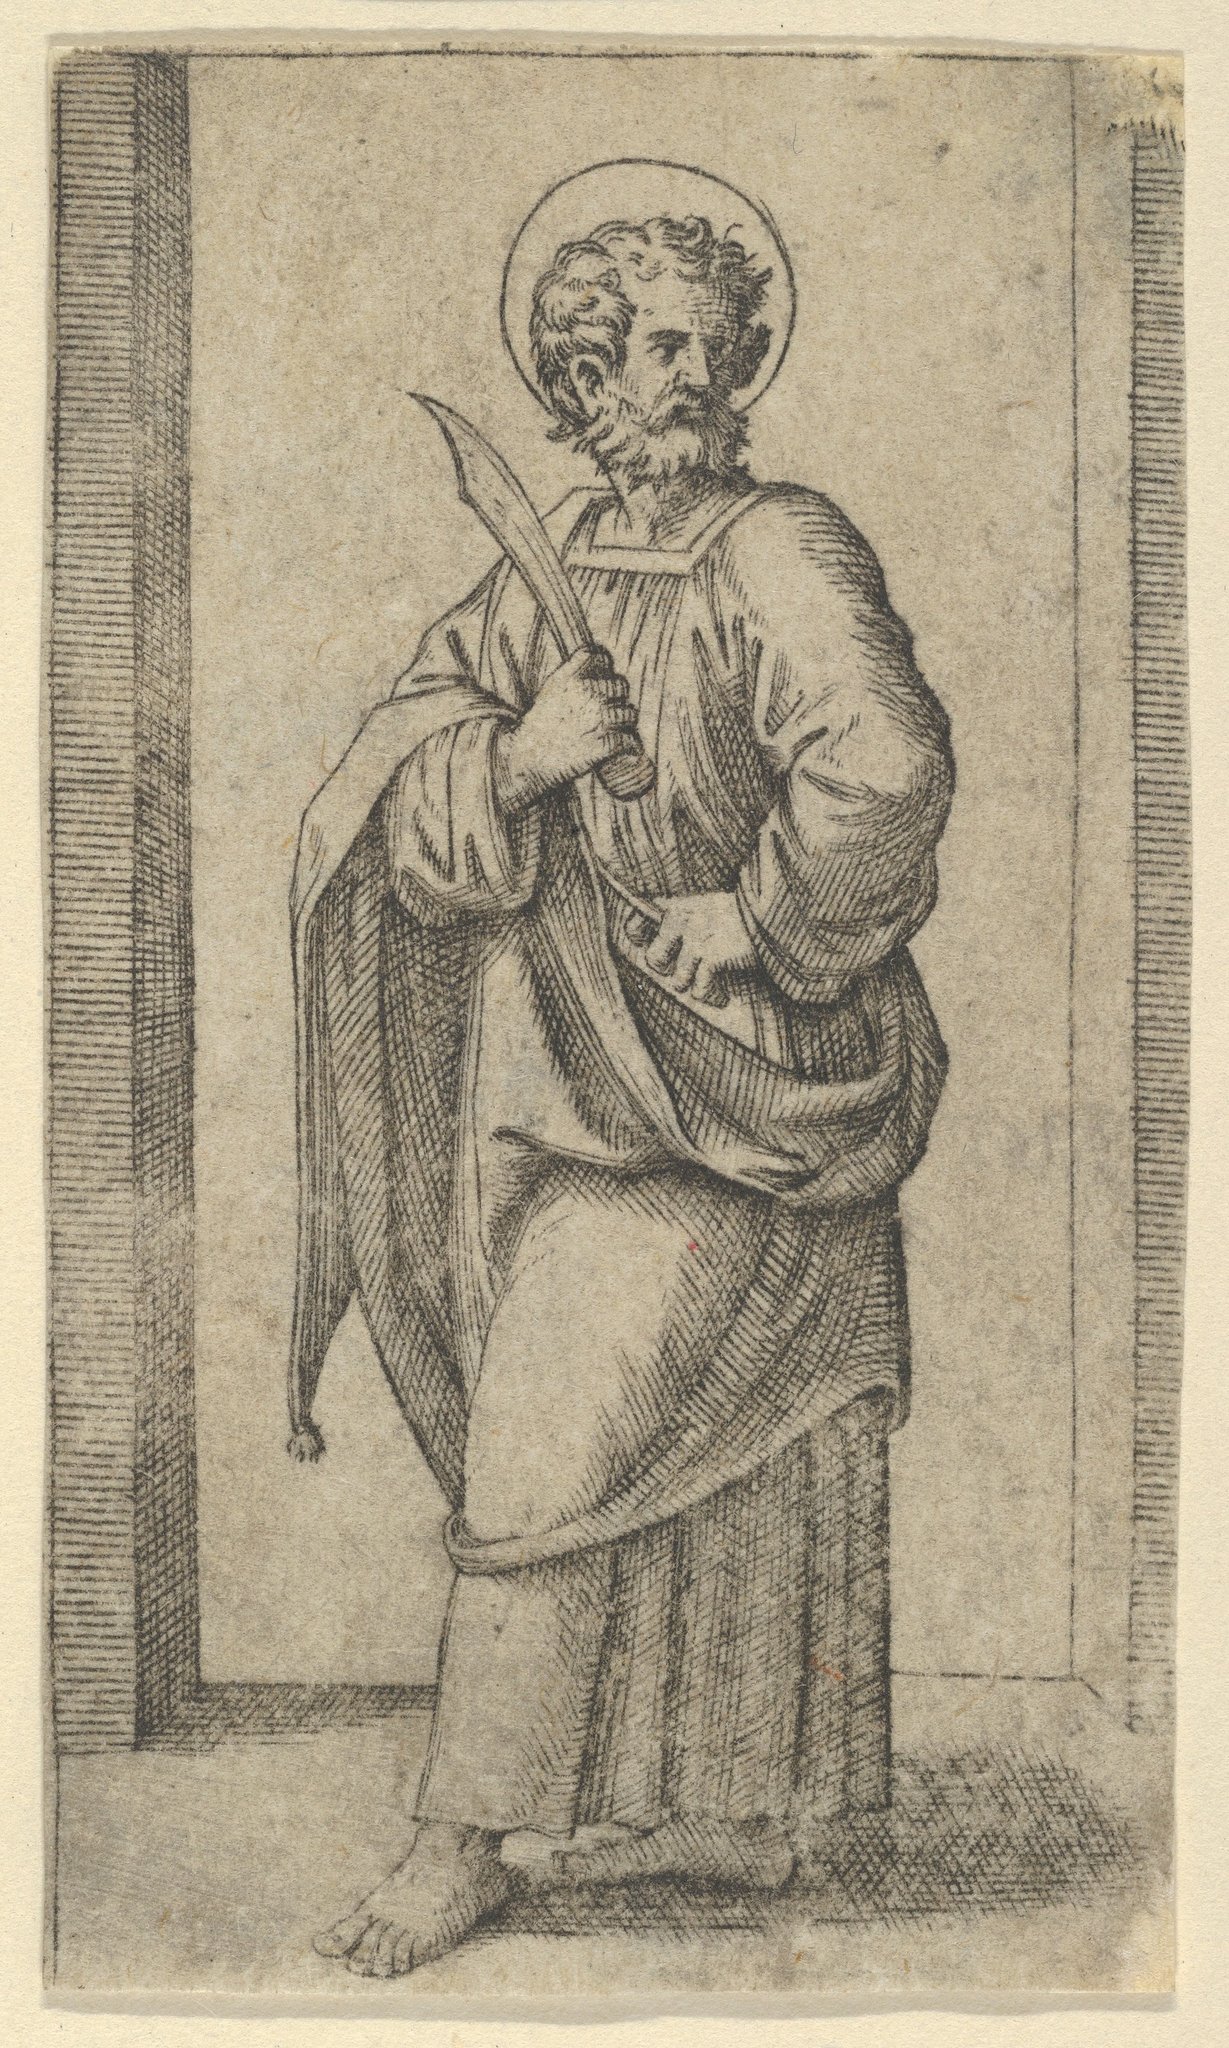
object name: print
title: Saint Bartholomew, knife in his right hand, from "Piccoli Santi" (Small Saints)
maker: marcantonio raimondi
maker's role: artist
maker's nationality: italian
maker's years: 1475-1534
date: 1500-1527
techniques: engraving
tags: knives,saints